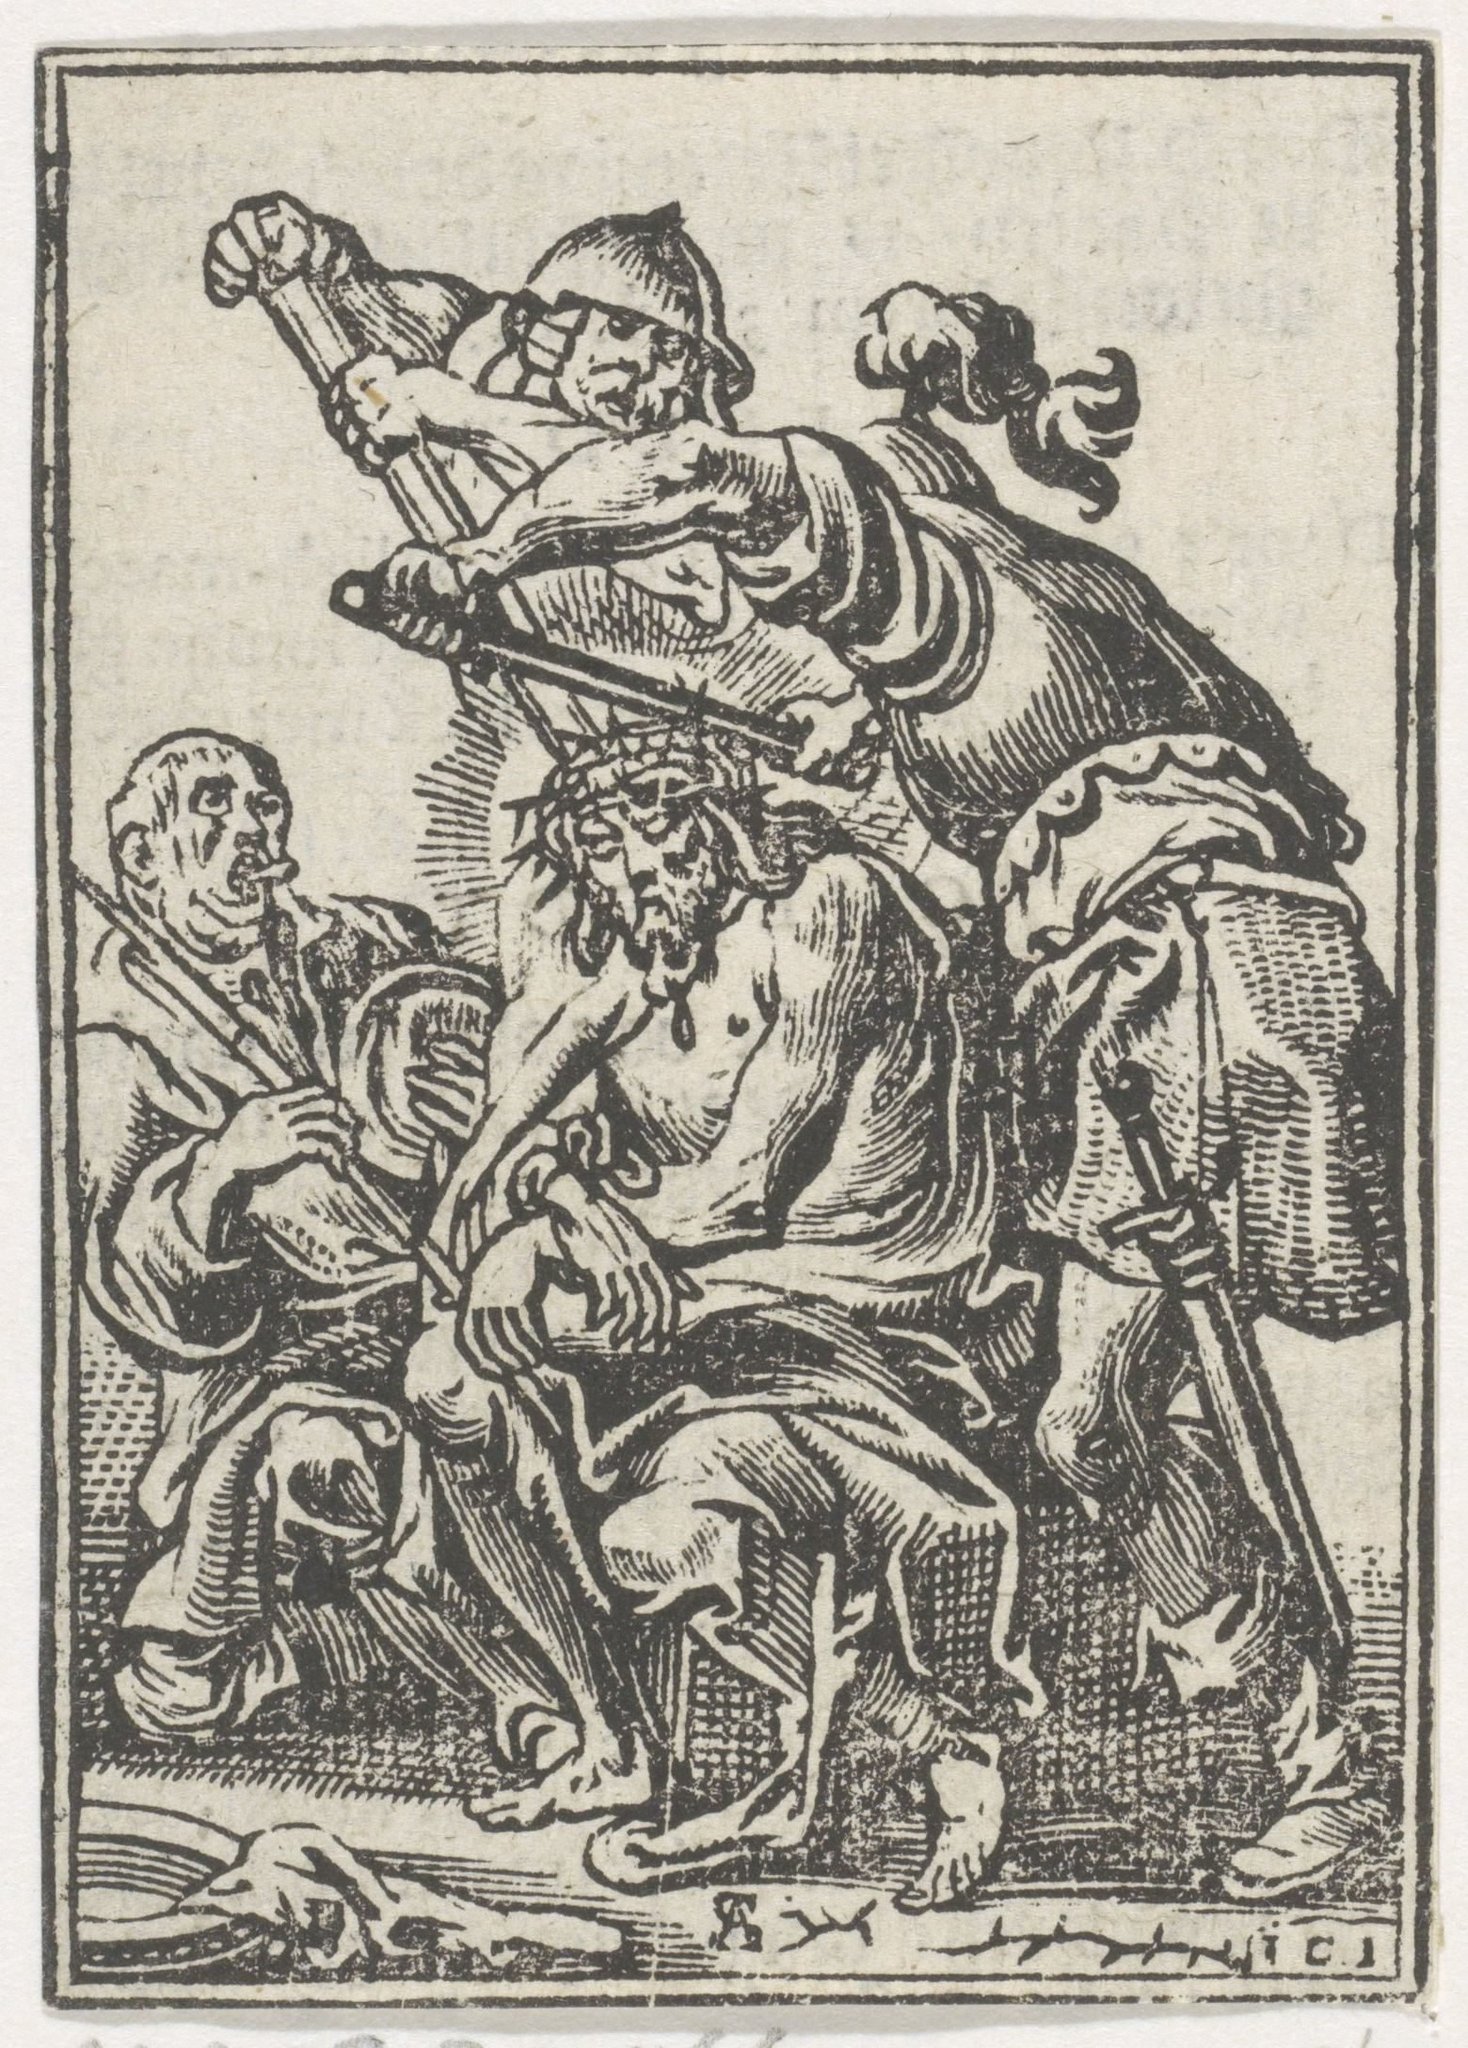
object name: book illustration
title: Doornenkroning van Christus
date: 1649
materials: paper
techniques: letterpress printing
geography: antwerp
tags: the crowning with thorns: soldiers with sticks place a thorny crown on christ's head and give him a reed (matthew 27:27-31; mark 15:16-20; john 19:2-3)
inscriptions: collector's mark: Lugt 2228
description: Soldaten zetten Christus met stokken een doornenkroon op het hoofd. Een man knielt voor hem en geeft hem een rietstok in de hand.